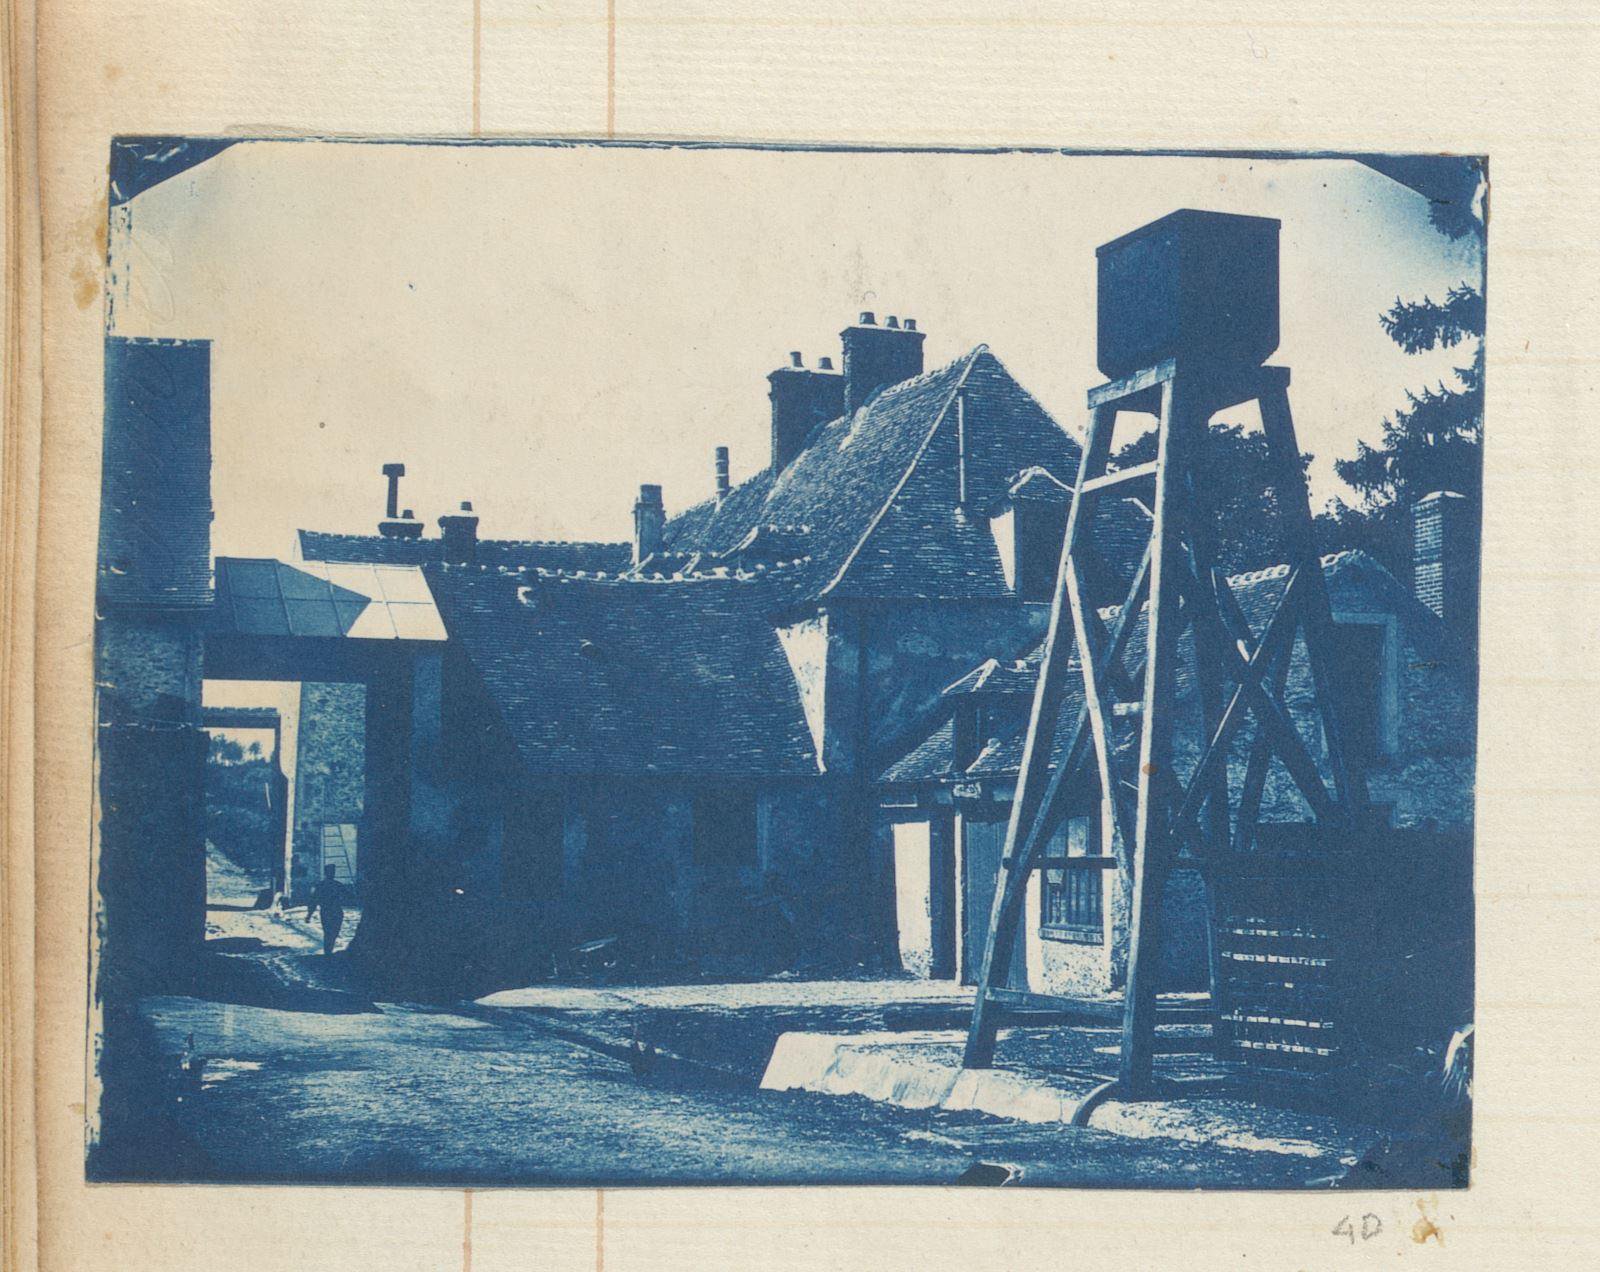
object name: photograph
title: Boerderij met erf en watertoren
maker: Anonymous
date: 1880-1900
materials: paper, photographic support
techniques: cyanotype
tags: water tower, farm (building)